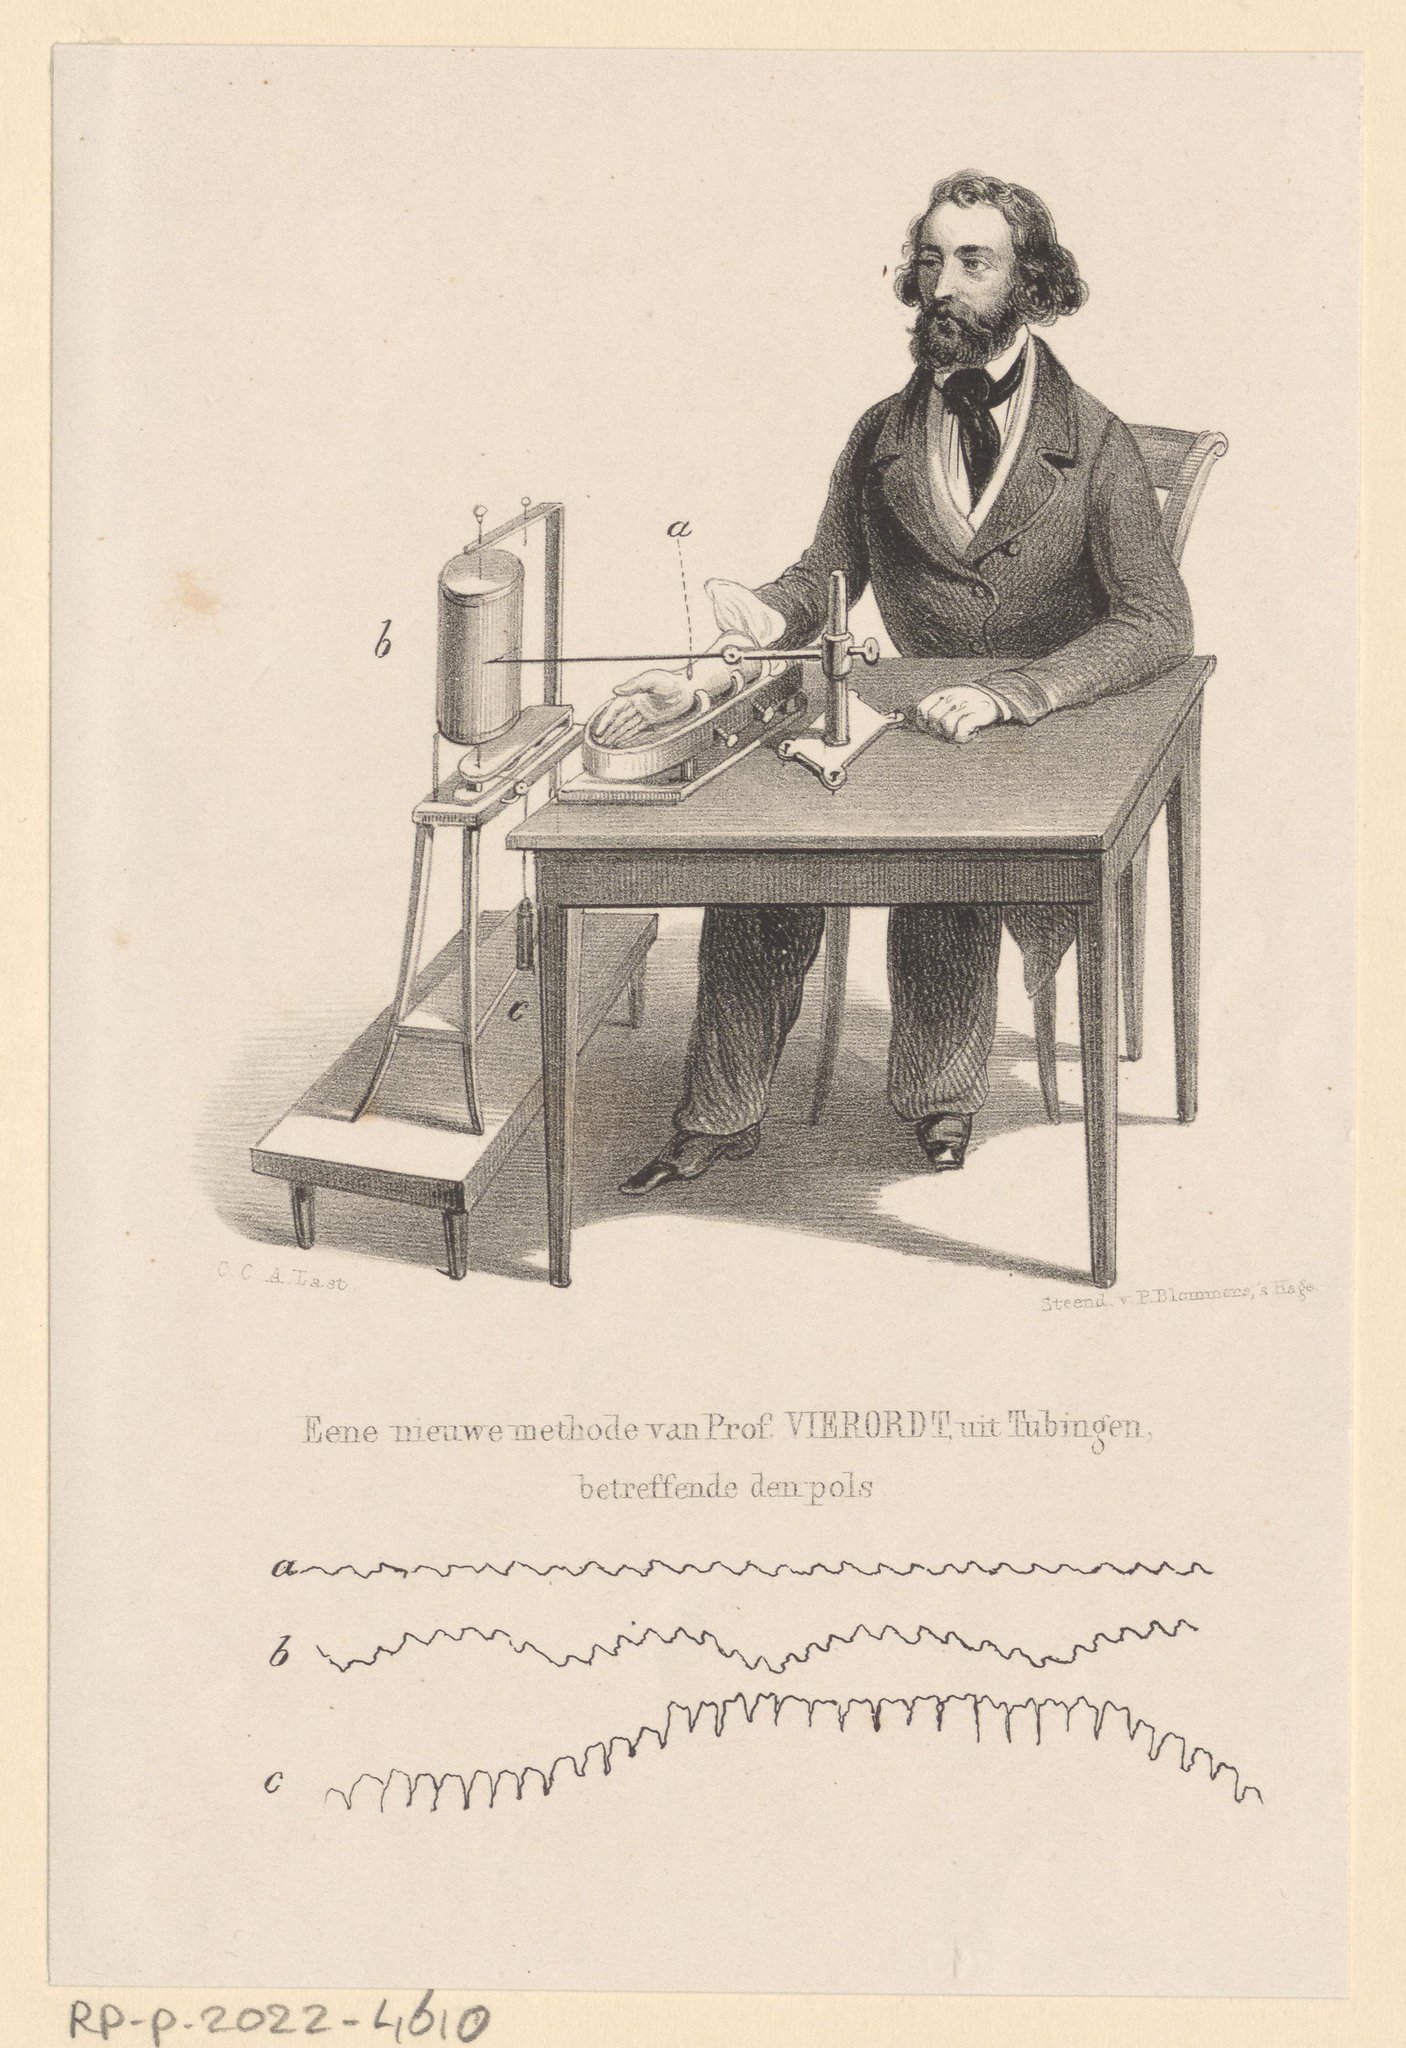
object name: print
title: Portret van Karl von Vierordt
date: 1853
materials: paper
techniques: lithograph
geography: the hague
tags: scholar, philosopher, historical persons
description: Prent waarschijnlijk uit: De tijd, merkwaardigheden der letterkunde en geschiedenis van den dag voor de beschaafde wereld (...). Den Haag: Jacobus Leunis van der Vliet, 1853, dl. 17, p. 348-349.